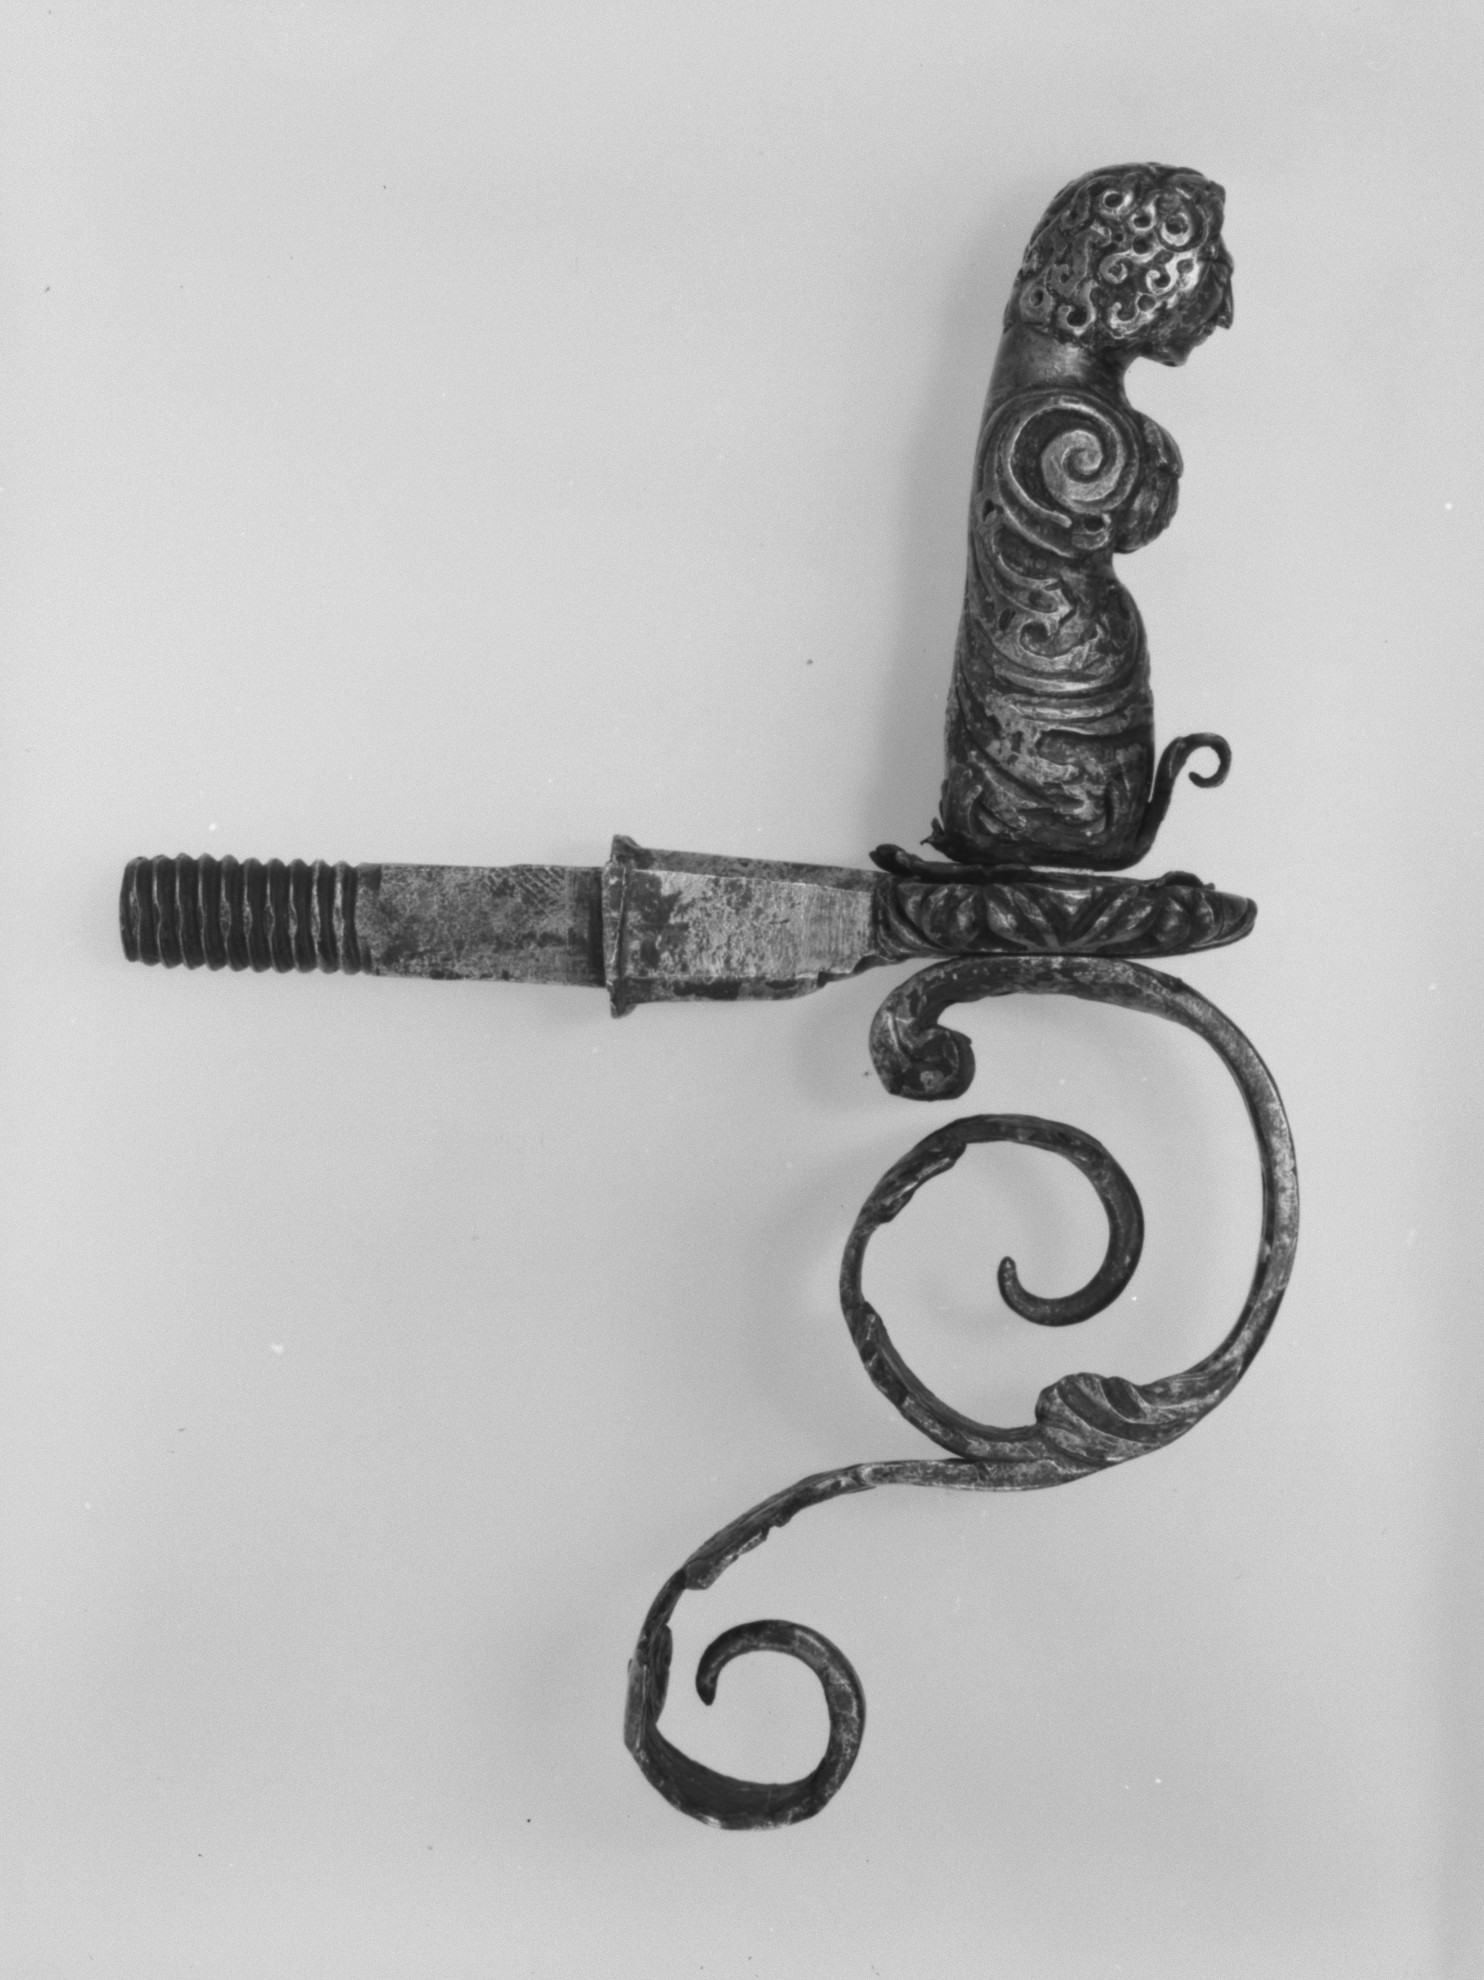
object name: door handle or bracket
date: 1500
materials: iron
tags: human figures